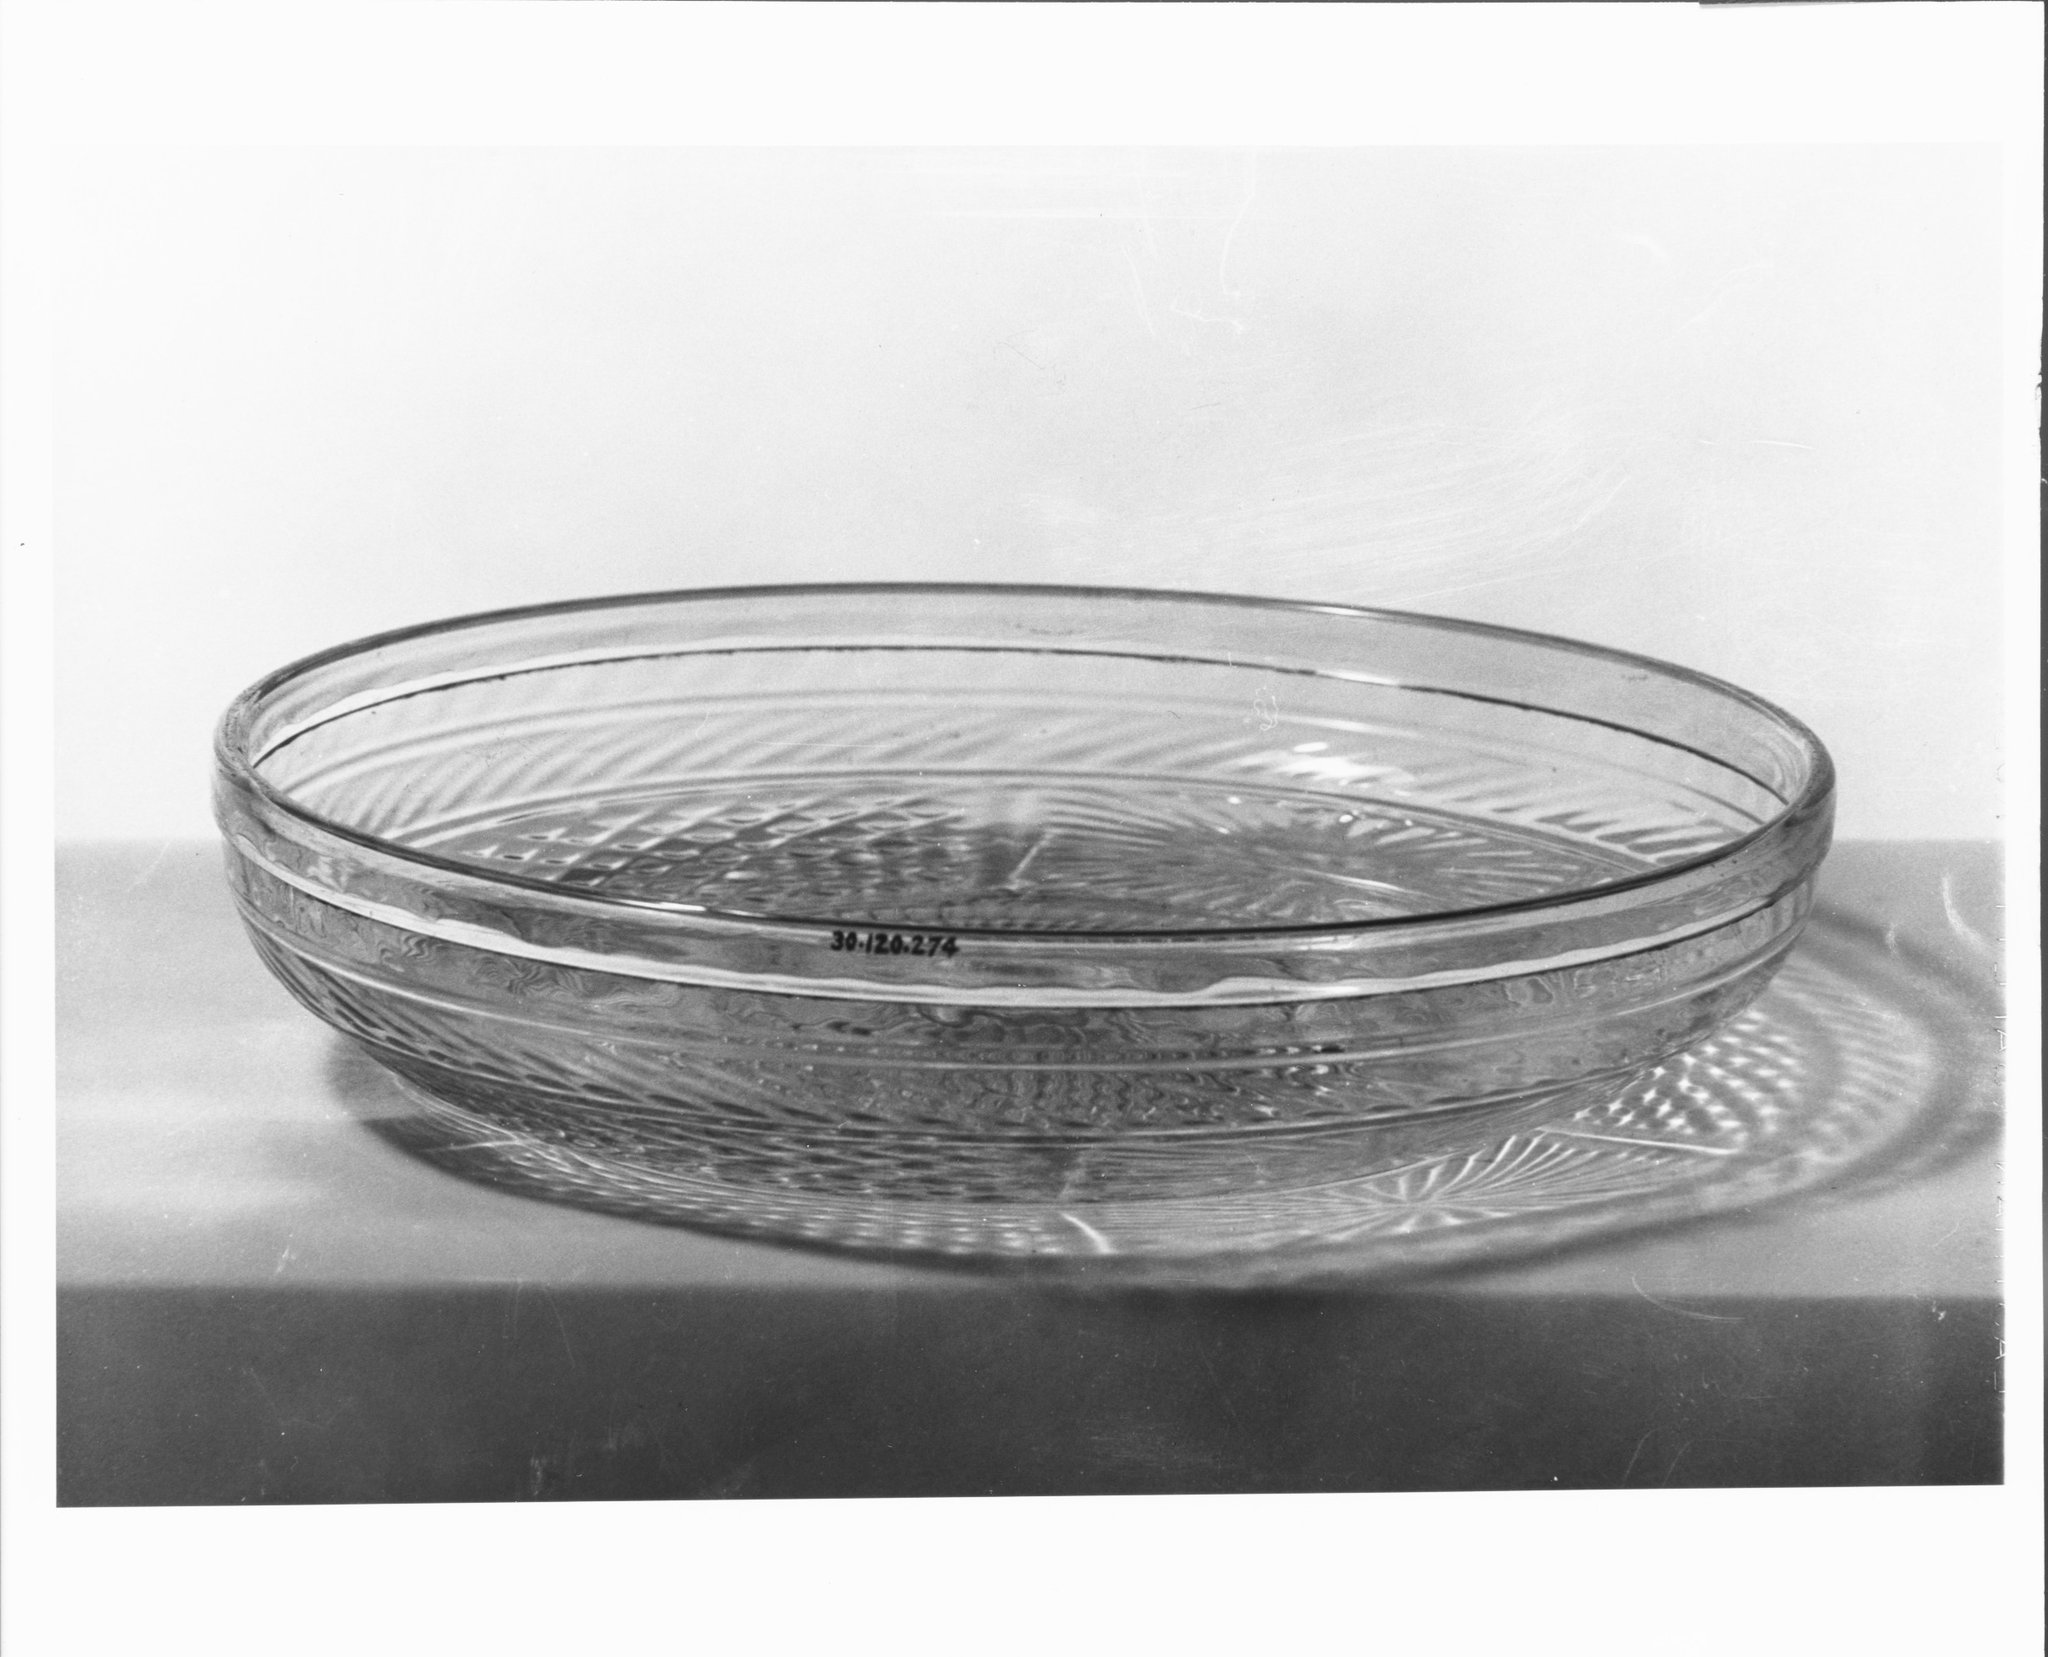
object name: dish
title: Rayed Dish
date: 1820-1840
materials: glass, lead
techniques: glassblowing, molding